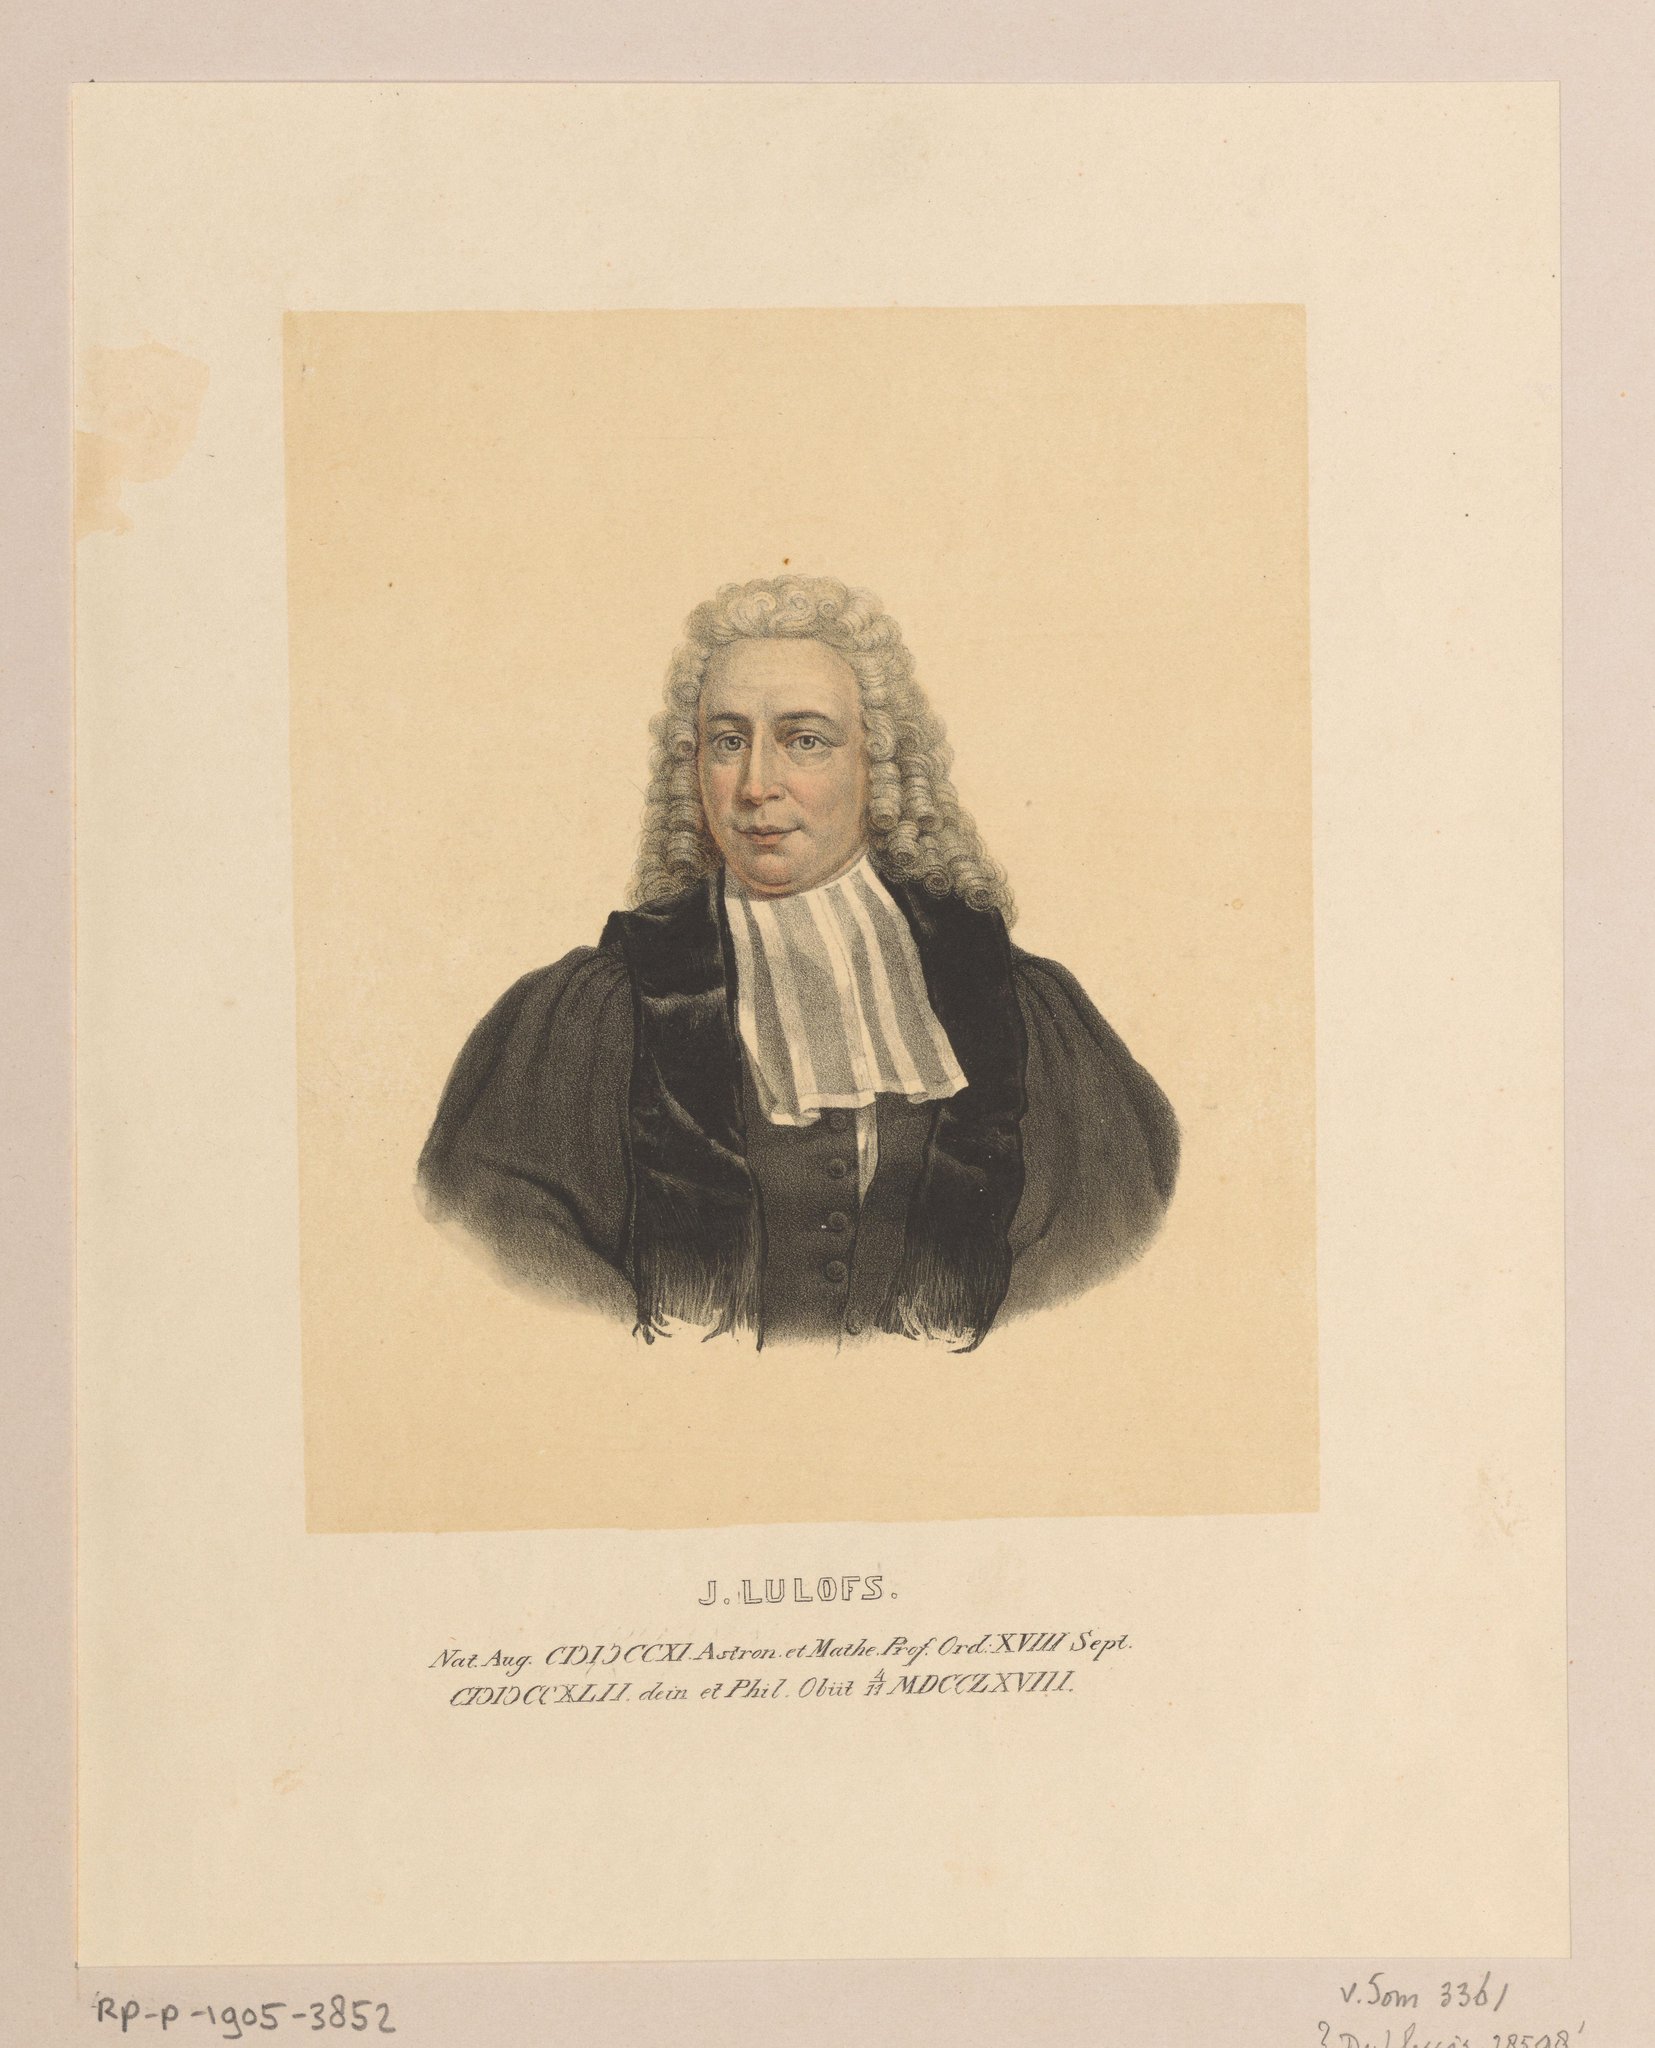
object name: print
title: Portretten van Leidse hoogleraren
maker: leendert springer (i)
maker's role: draughtsman, painter, print maker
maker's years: 1789-1871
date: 1850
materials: paper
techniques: hand coloring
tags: johannes lulofs, historical persons, professor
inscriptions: collector's mark: Lugt 2228